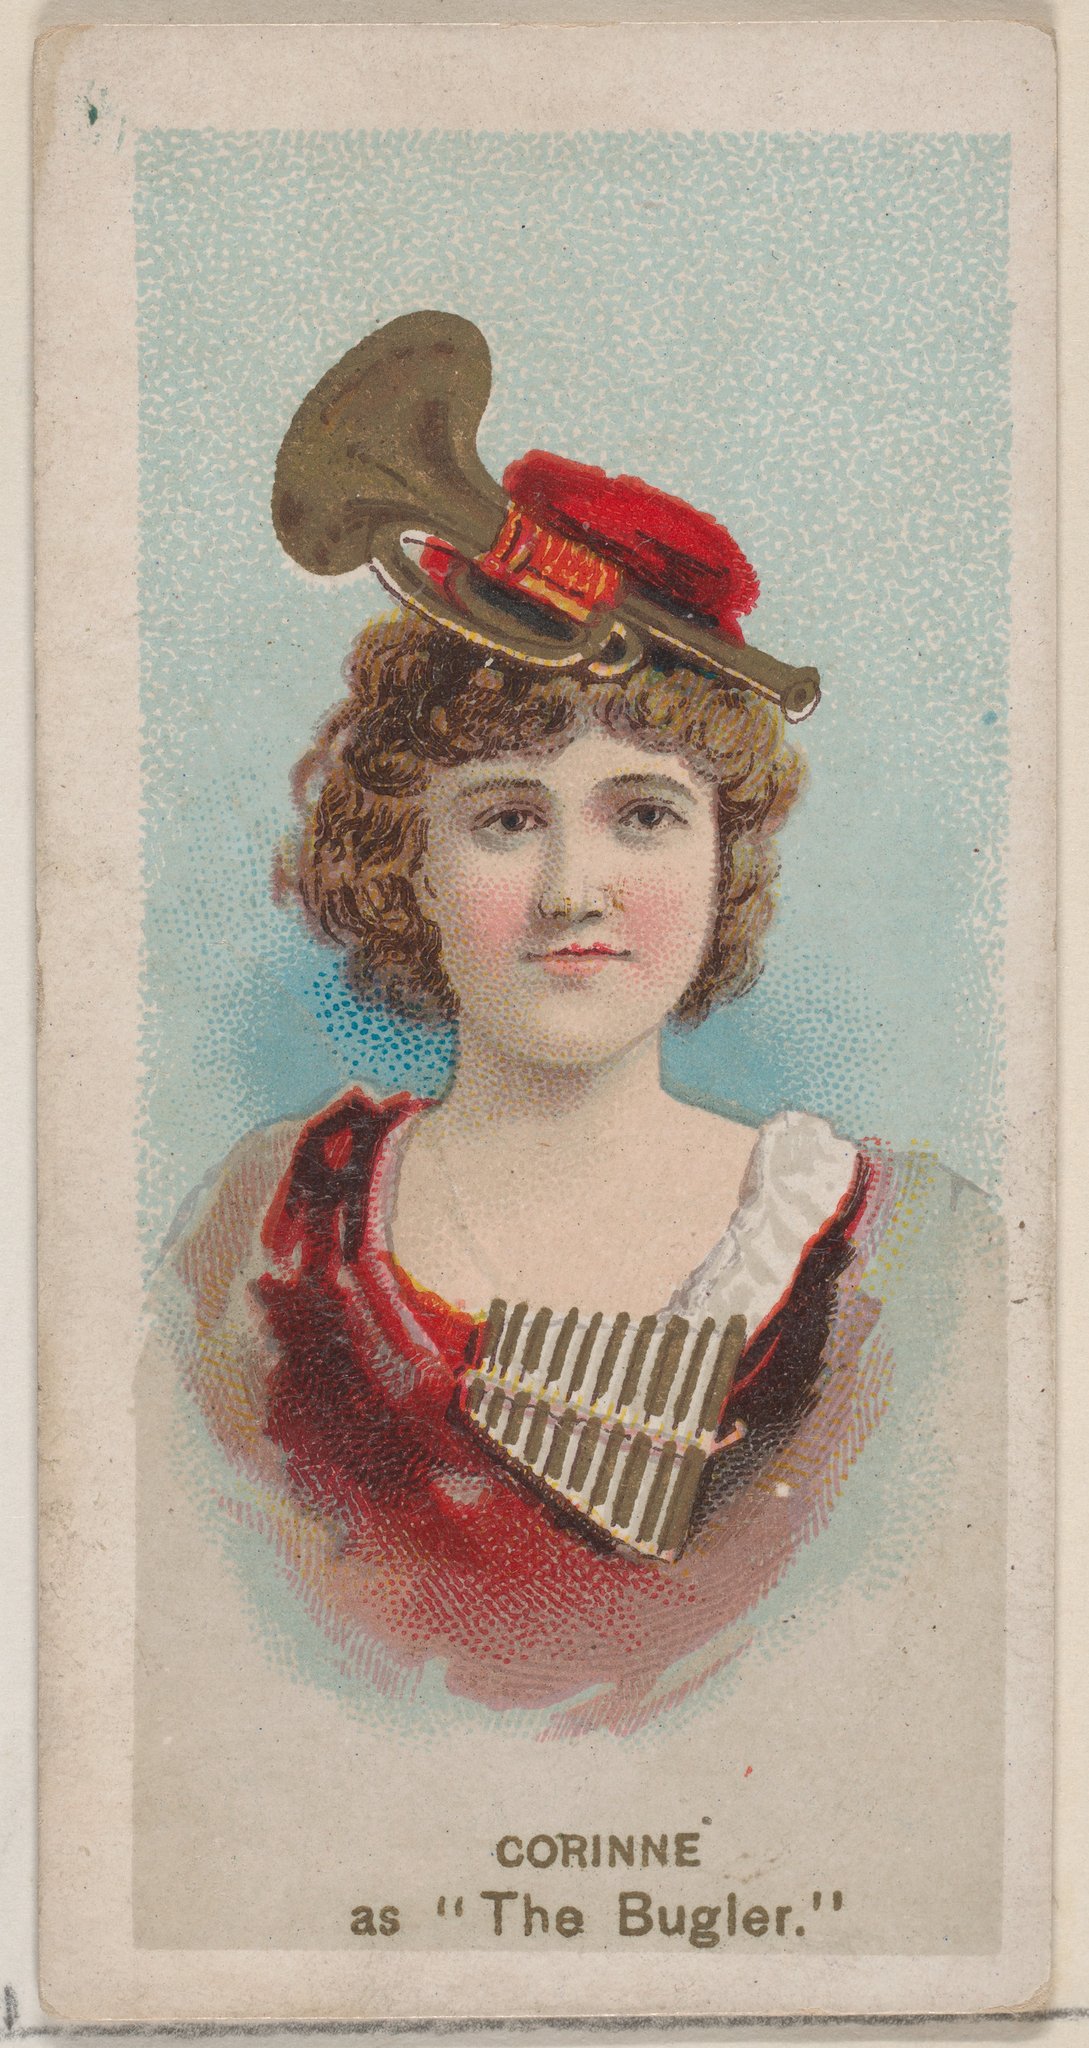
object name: print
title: Corinne as "The Bugler," from the series Fancy Dress Ball Costumes (N73) for Duke brand cigarettes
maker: w. duke, sons & co.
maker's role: publisher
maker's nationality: american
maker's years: 1870-1920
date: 1889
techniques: color lithograph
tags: musical instruments,women,actresses